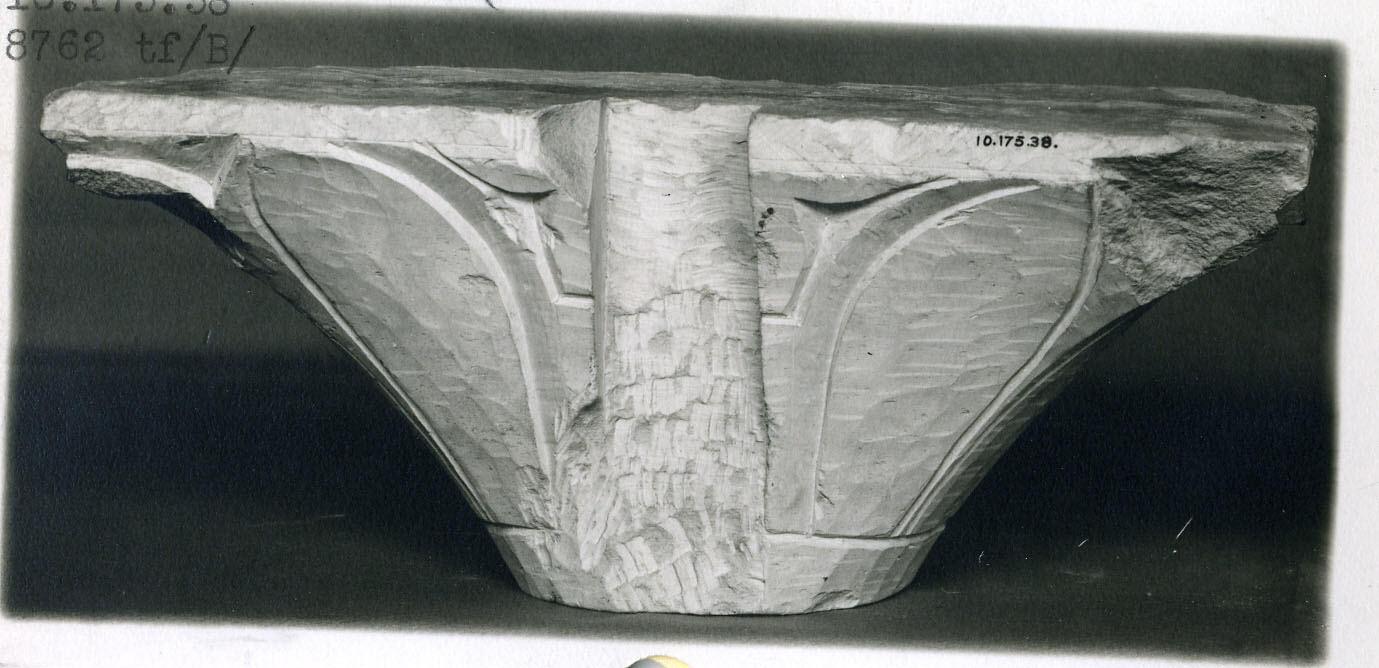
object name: capital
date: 501-700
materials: limestone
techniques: carving, relief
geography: egypt